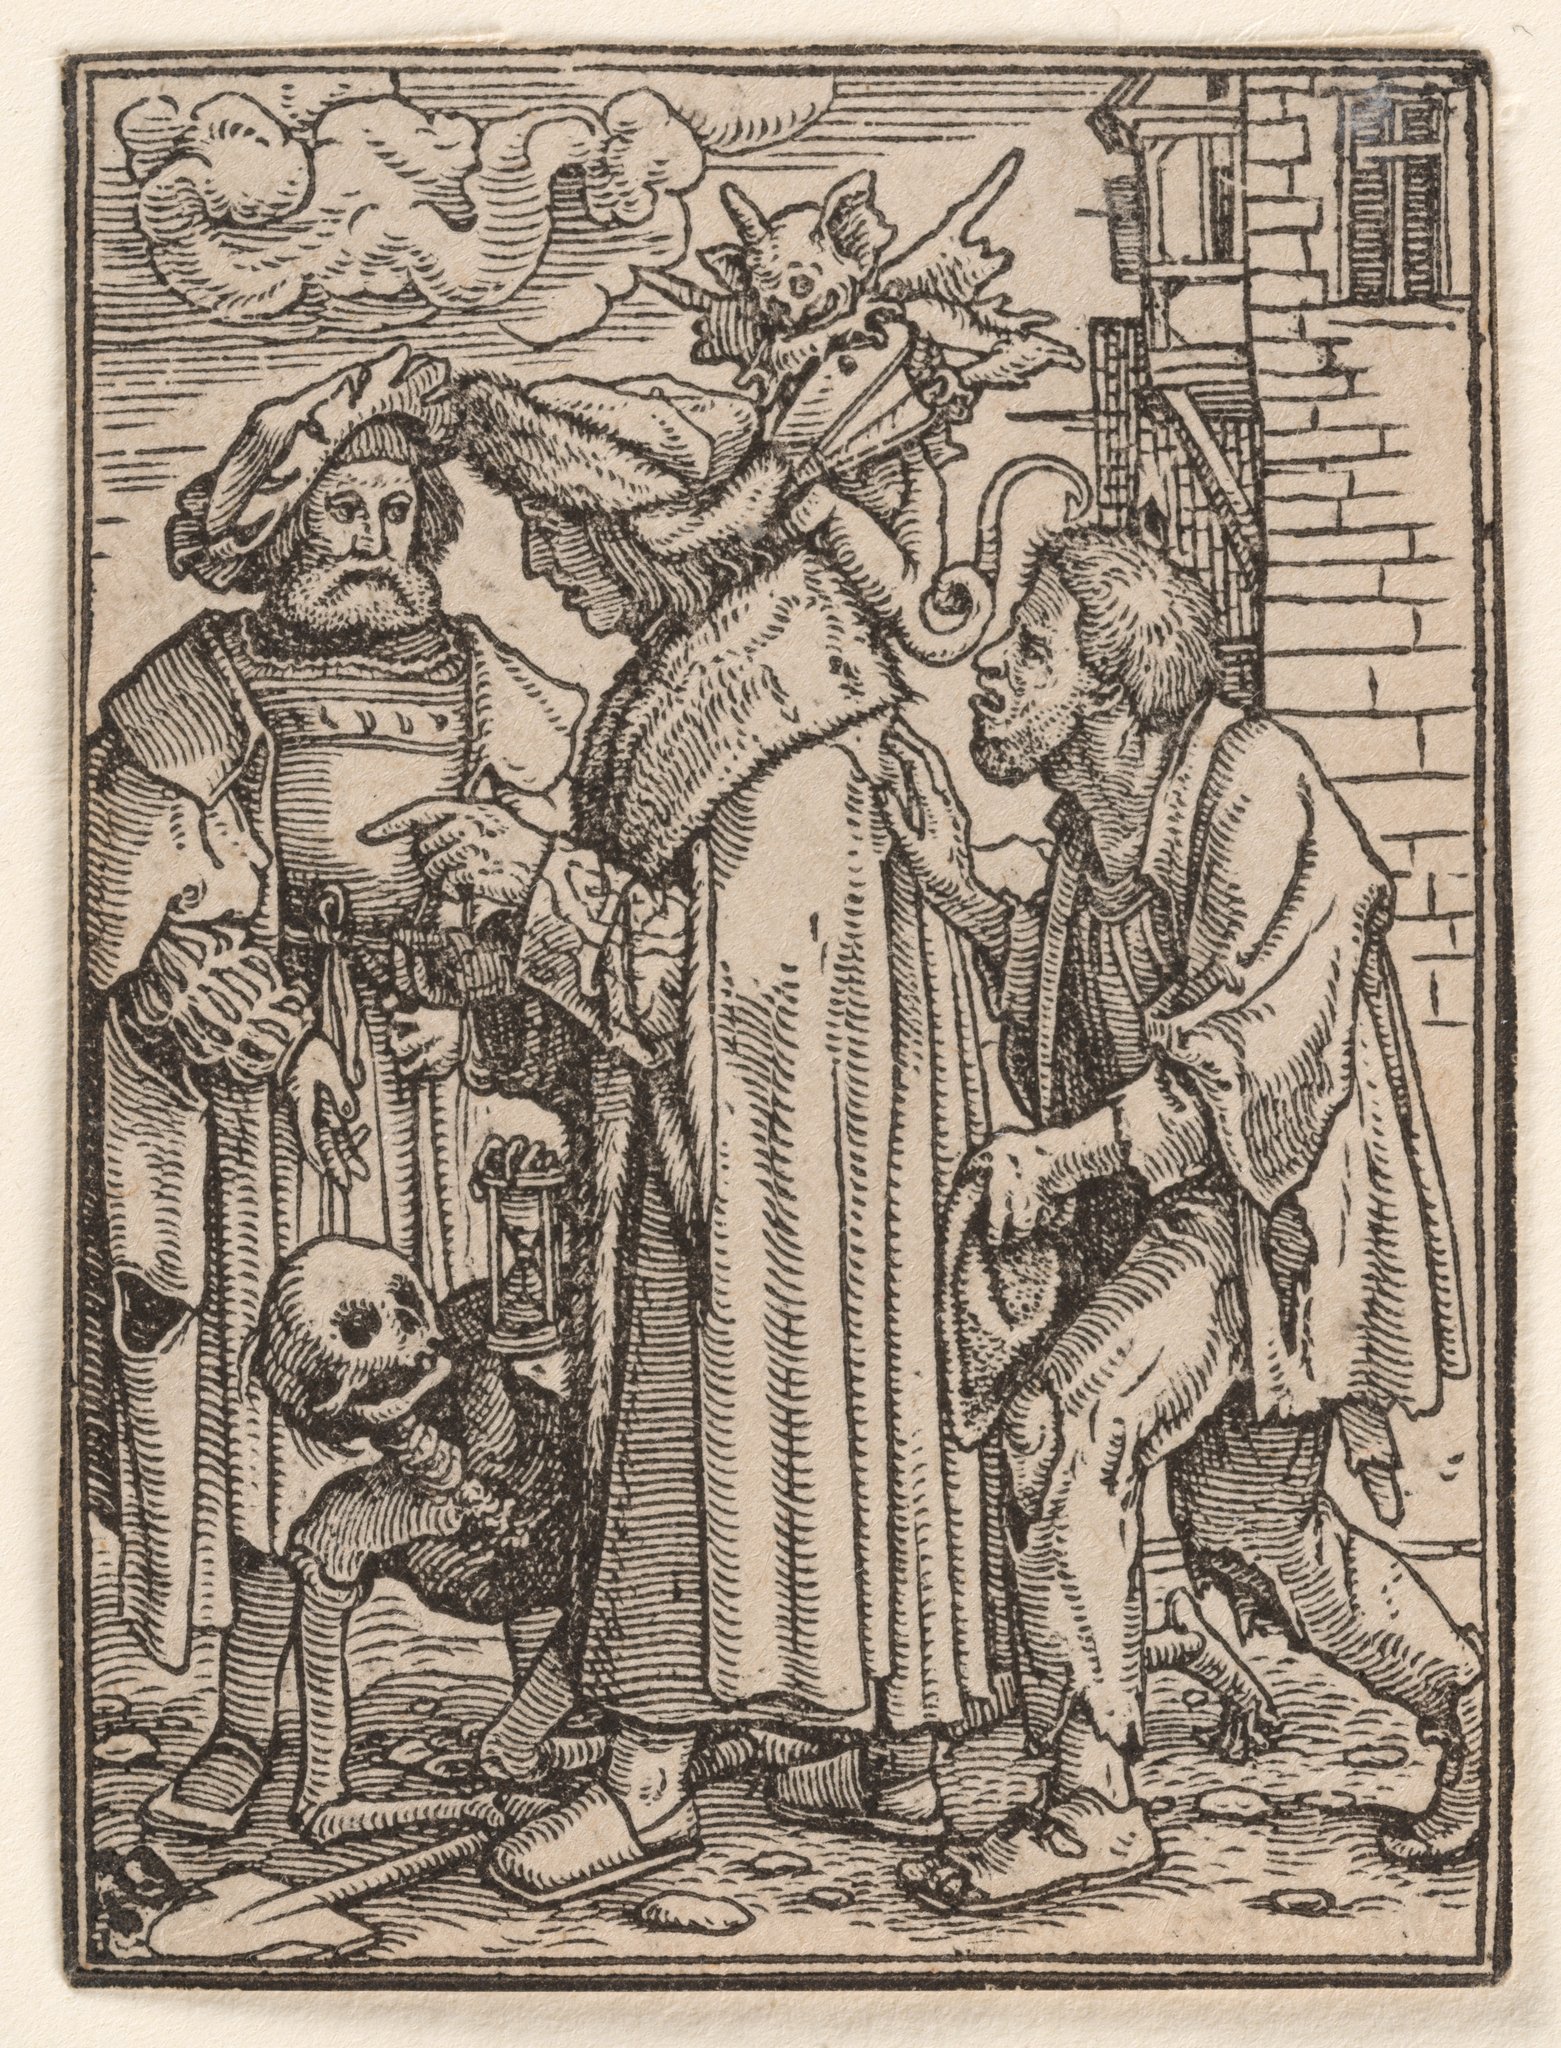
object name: print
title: The Councillor, from "The Dance of Death"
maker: hans holbein the younger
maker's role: artist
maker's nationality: german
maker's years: 1497-1543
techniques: woodcut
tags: skeletons,men,hourglass